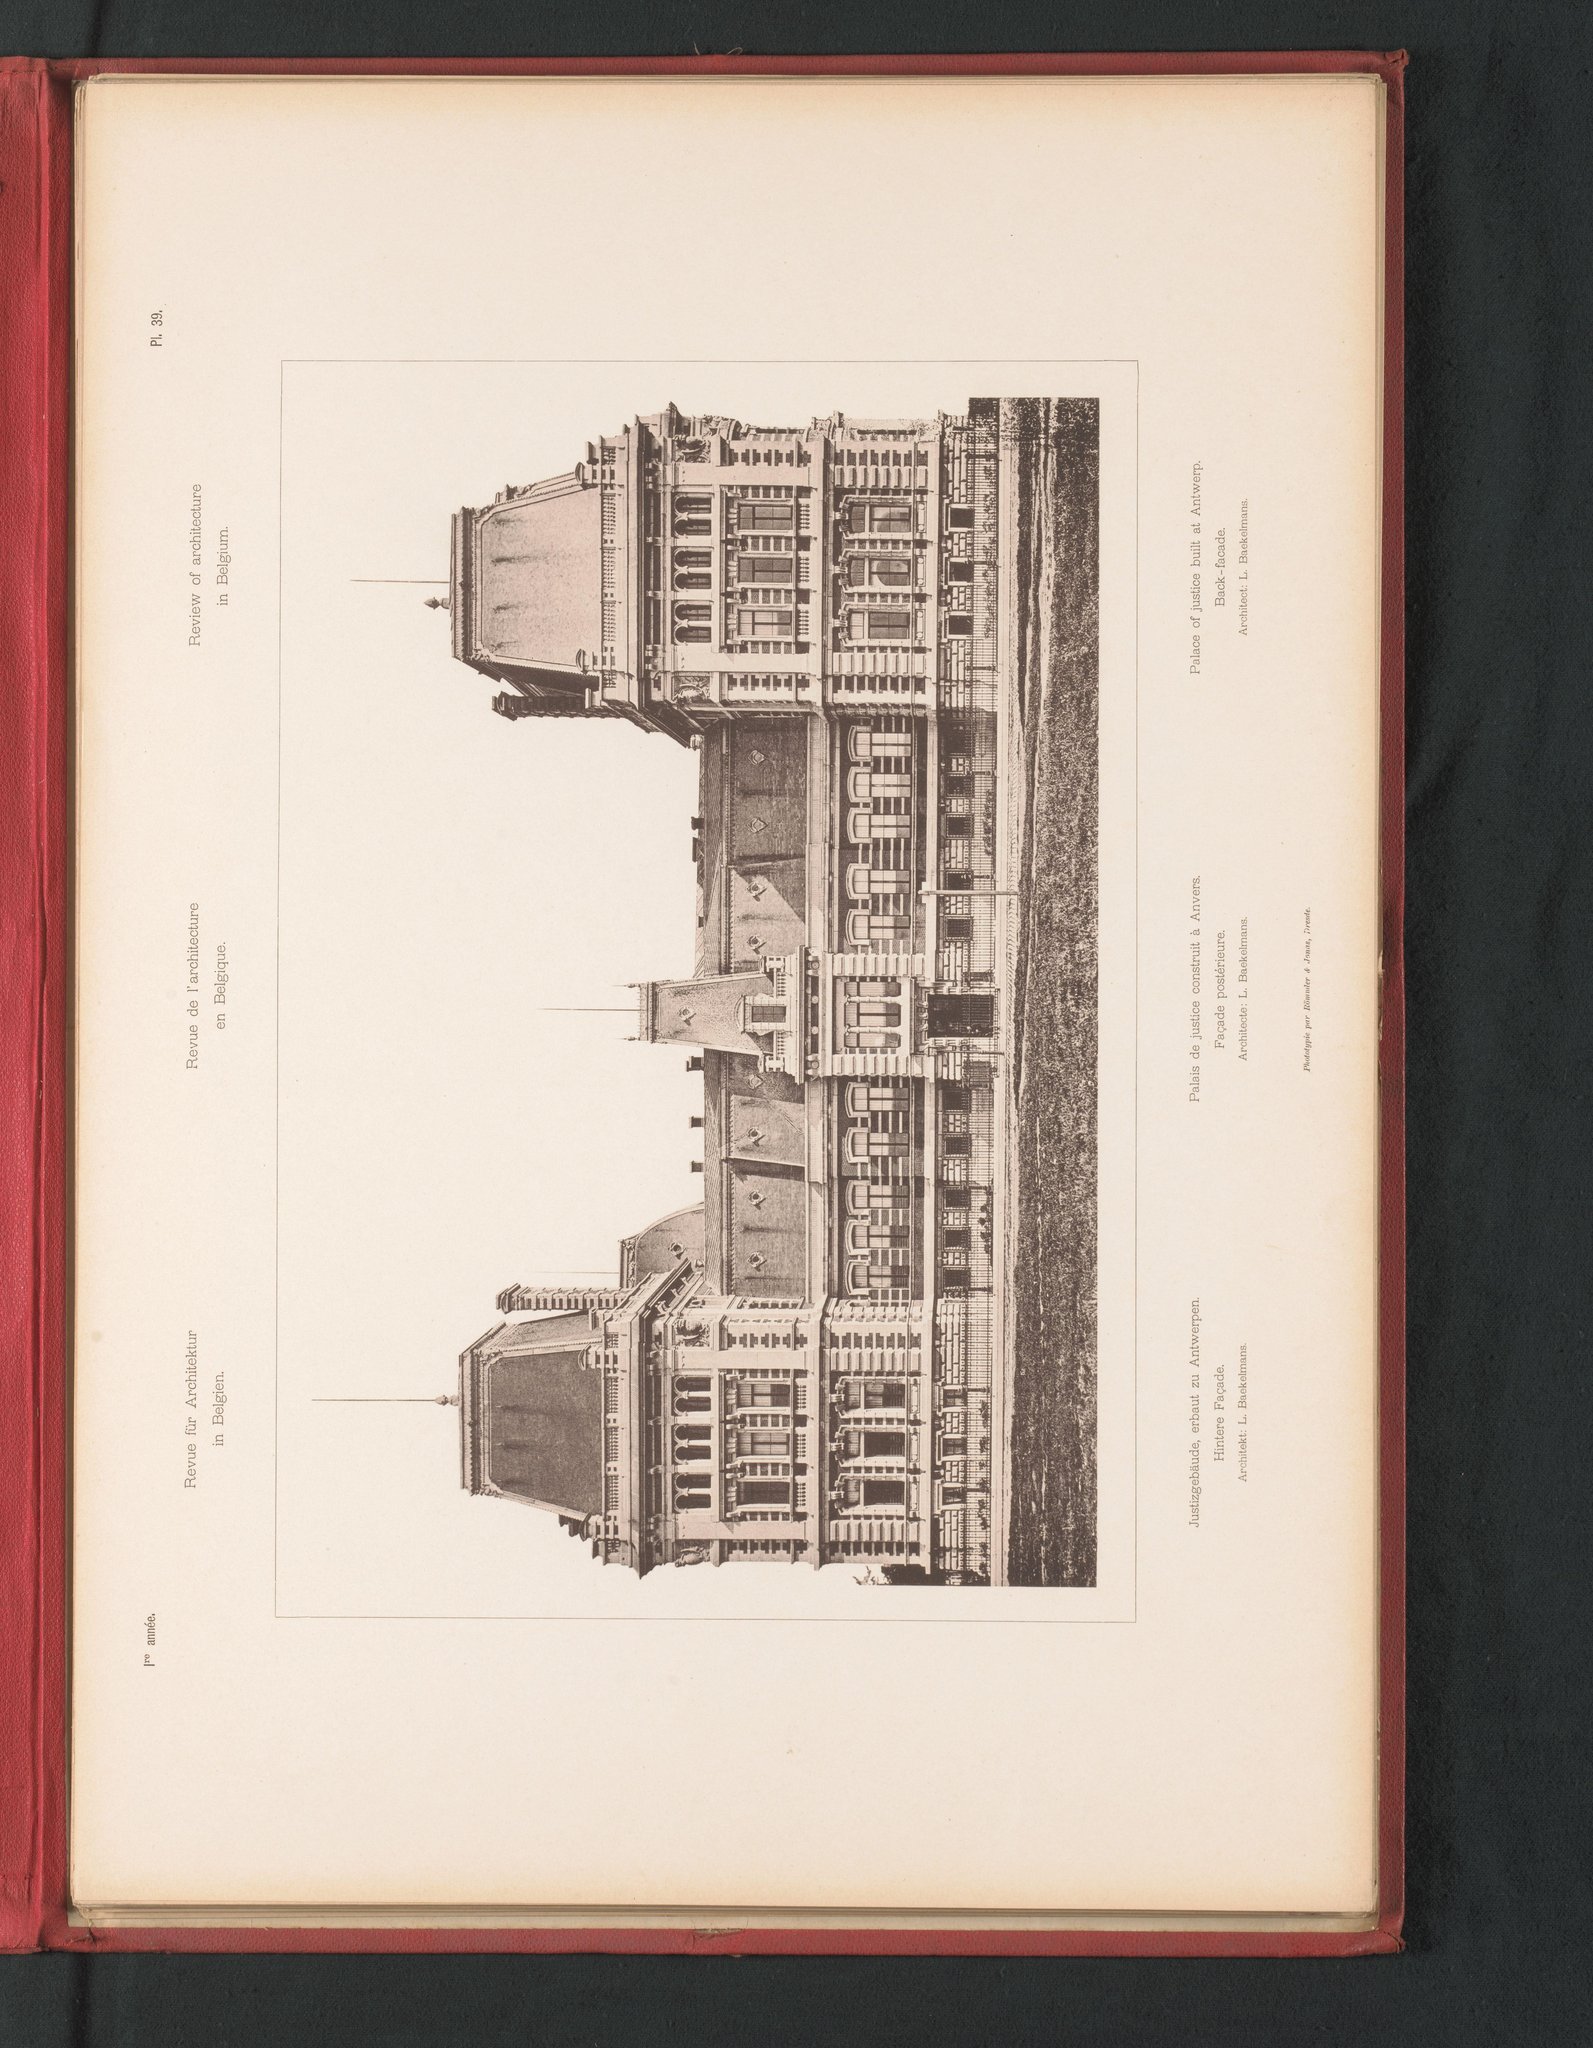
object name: photomechanical print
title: Gezicht op de achterzijde van het Paleis van Justitie in Antwerpen, België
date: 1888-1893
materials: paper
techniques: photograph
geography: dresden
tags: court building, antwerp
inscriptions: inscription: ‘Architect: L. Baeckelmans.’, number: ‘Pl. 39.’, inscription: ‘1re annèe.’, inscription: ‘Architecte: L. Baeckelmans.’, inscription: ‘Architekt: L. Baeckelmans.’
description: Deze prent maakt deel uit van een omslag met 110 prenten op 90 bladen en 18 tekstbladen.